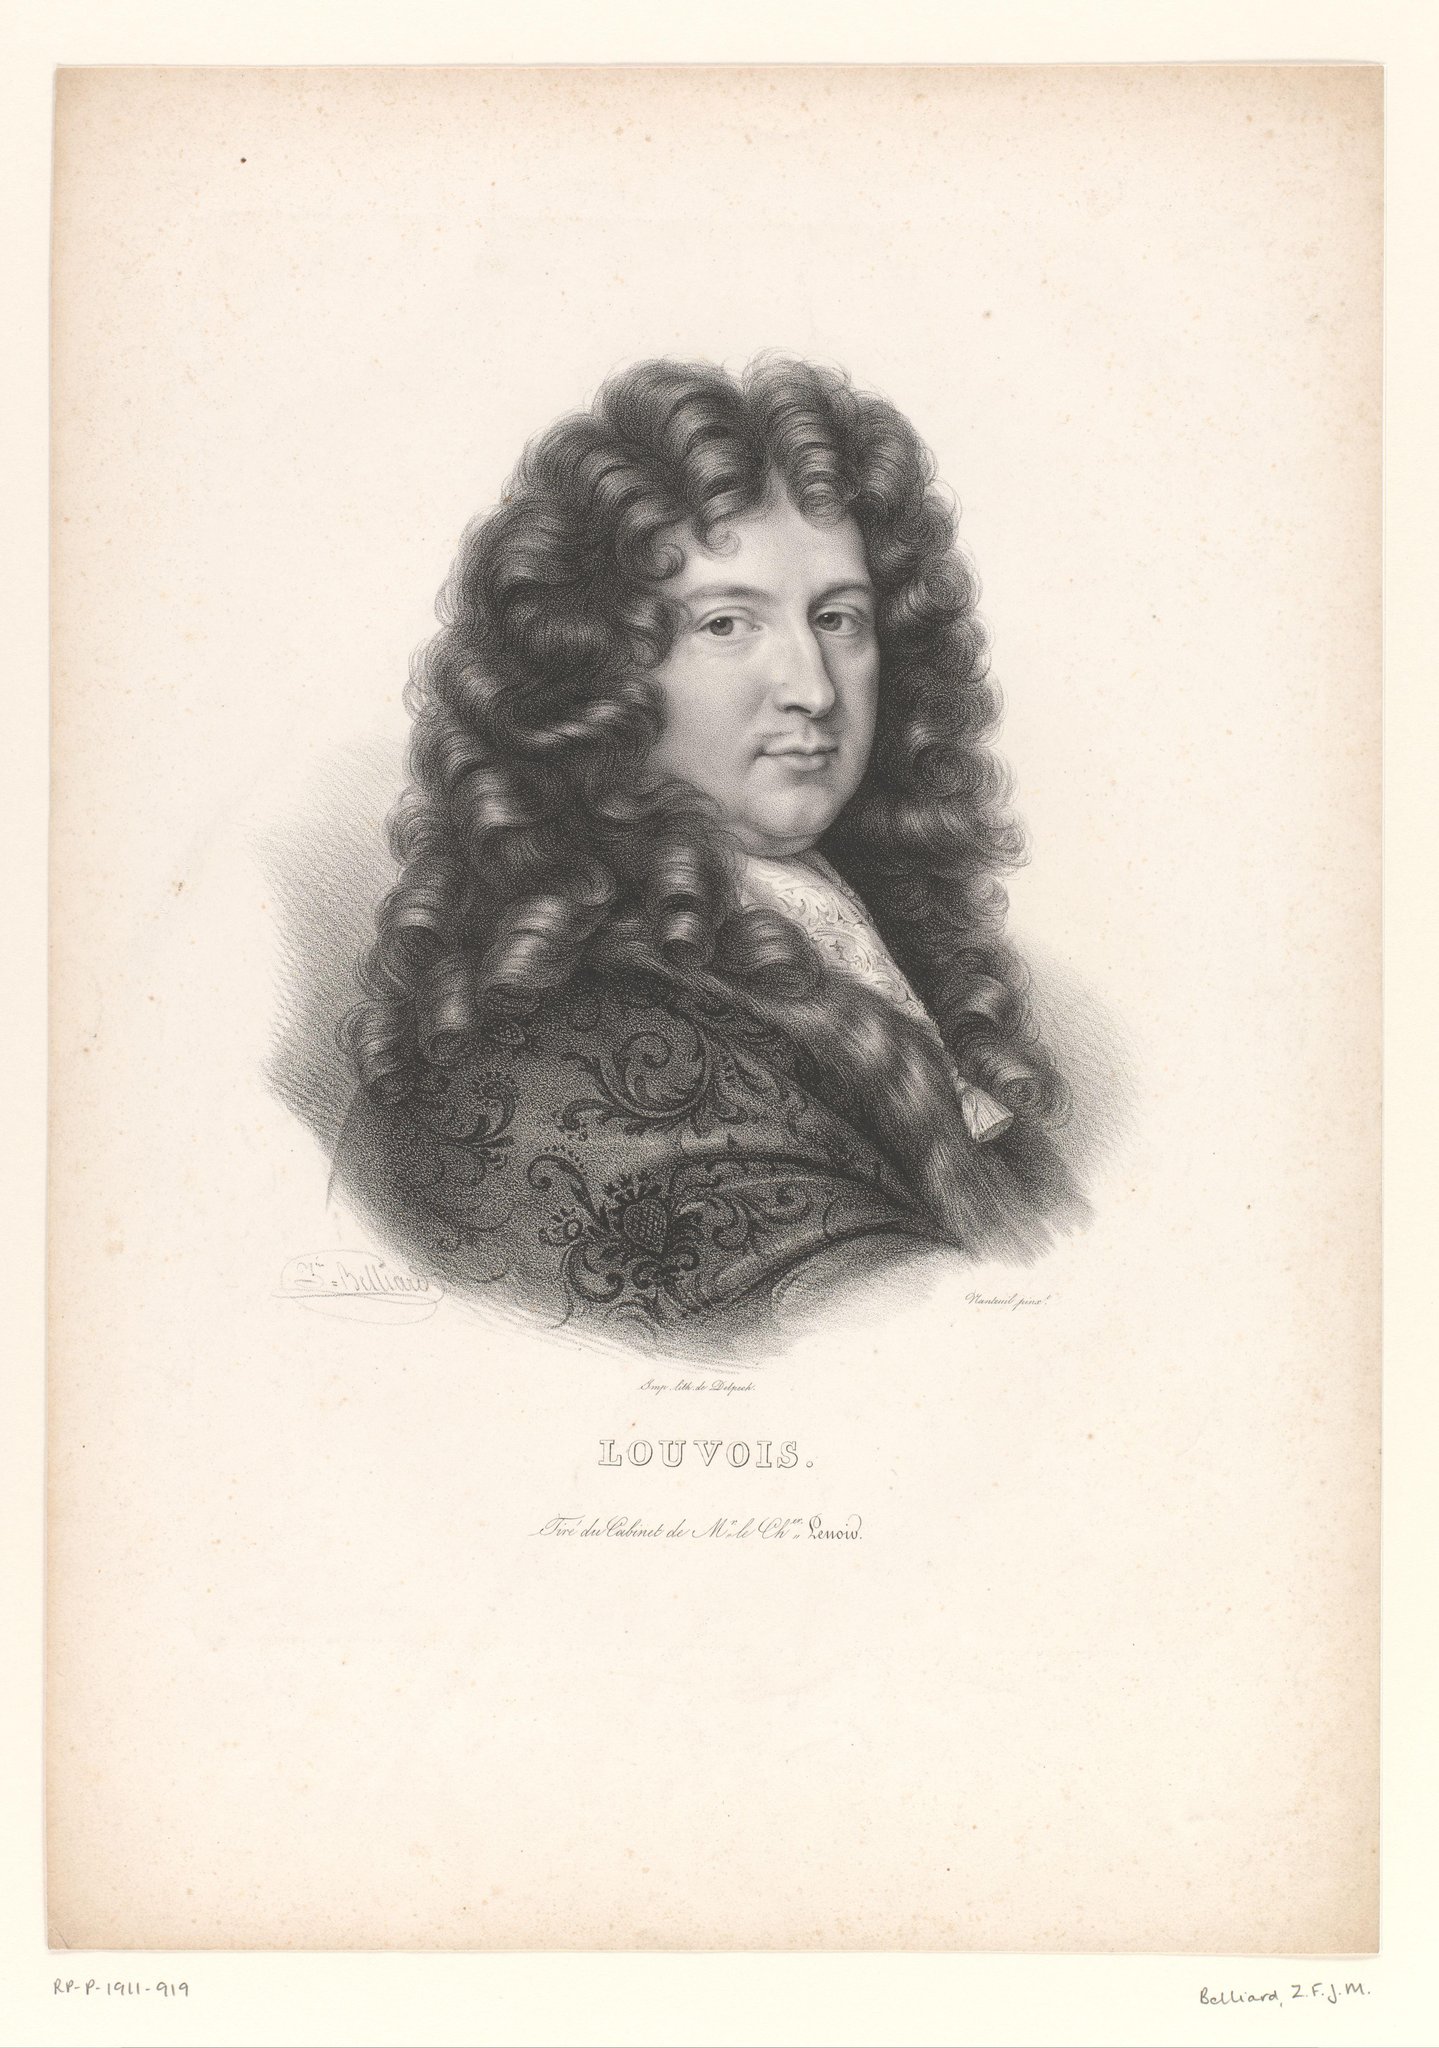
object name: print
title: Portret van minister François-Michel Le Tellier de Louvois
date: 1829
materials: paper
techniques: lithograph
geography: paris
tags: paris, françois-michel le tellier (markies de louvois), historical persons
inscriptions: collector's mark: Lugt 2228a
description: Prent gepubliceerd in: Iconographie française, ou Choix de deux cents portraits d'hommes et de femmes depuis le règne de Charles VII jusqu'à la fin de celui de Louis XVI, publié par Madame Delpech, Parijs 1840.